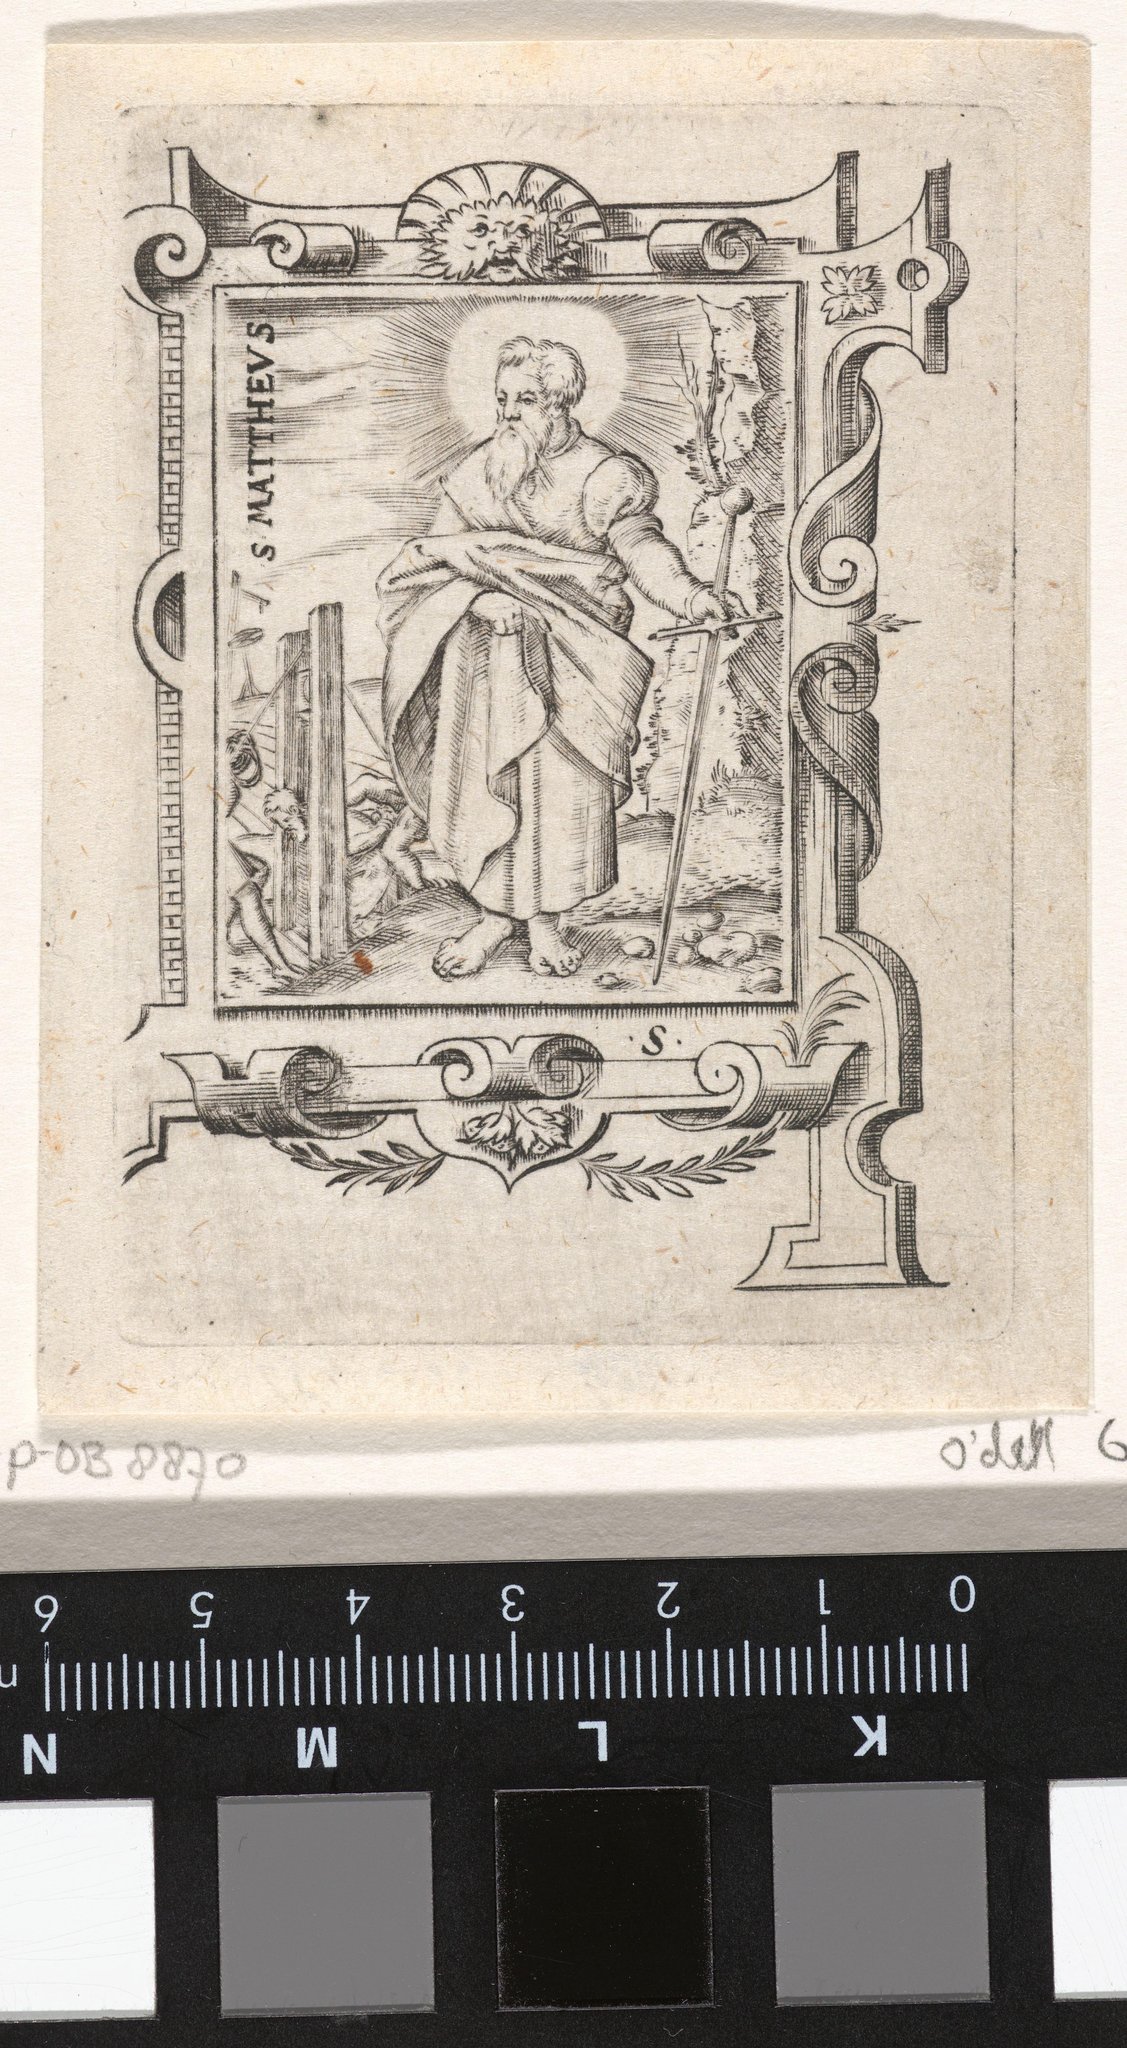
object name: print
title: H. Mattheus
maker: virgilius solis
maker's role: draughtsman, print maker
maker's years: 1514-1562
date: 1524-1562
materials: paper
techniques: engraving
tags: the apostle and evangelist matthew (mattheus); possible attributes: angel, axe, book, halberd, pen and inkhorn, purse, scroll, square, sword